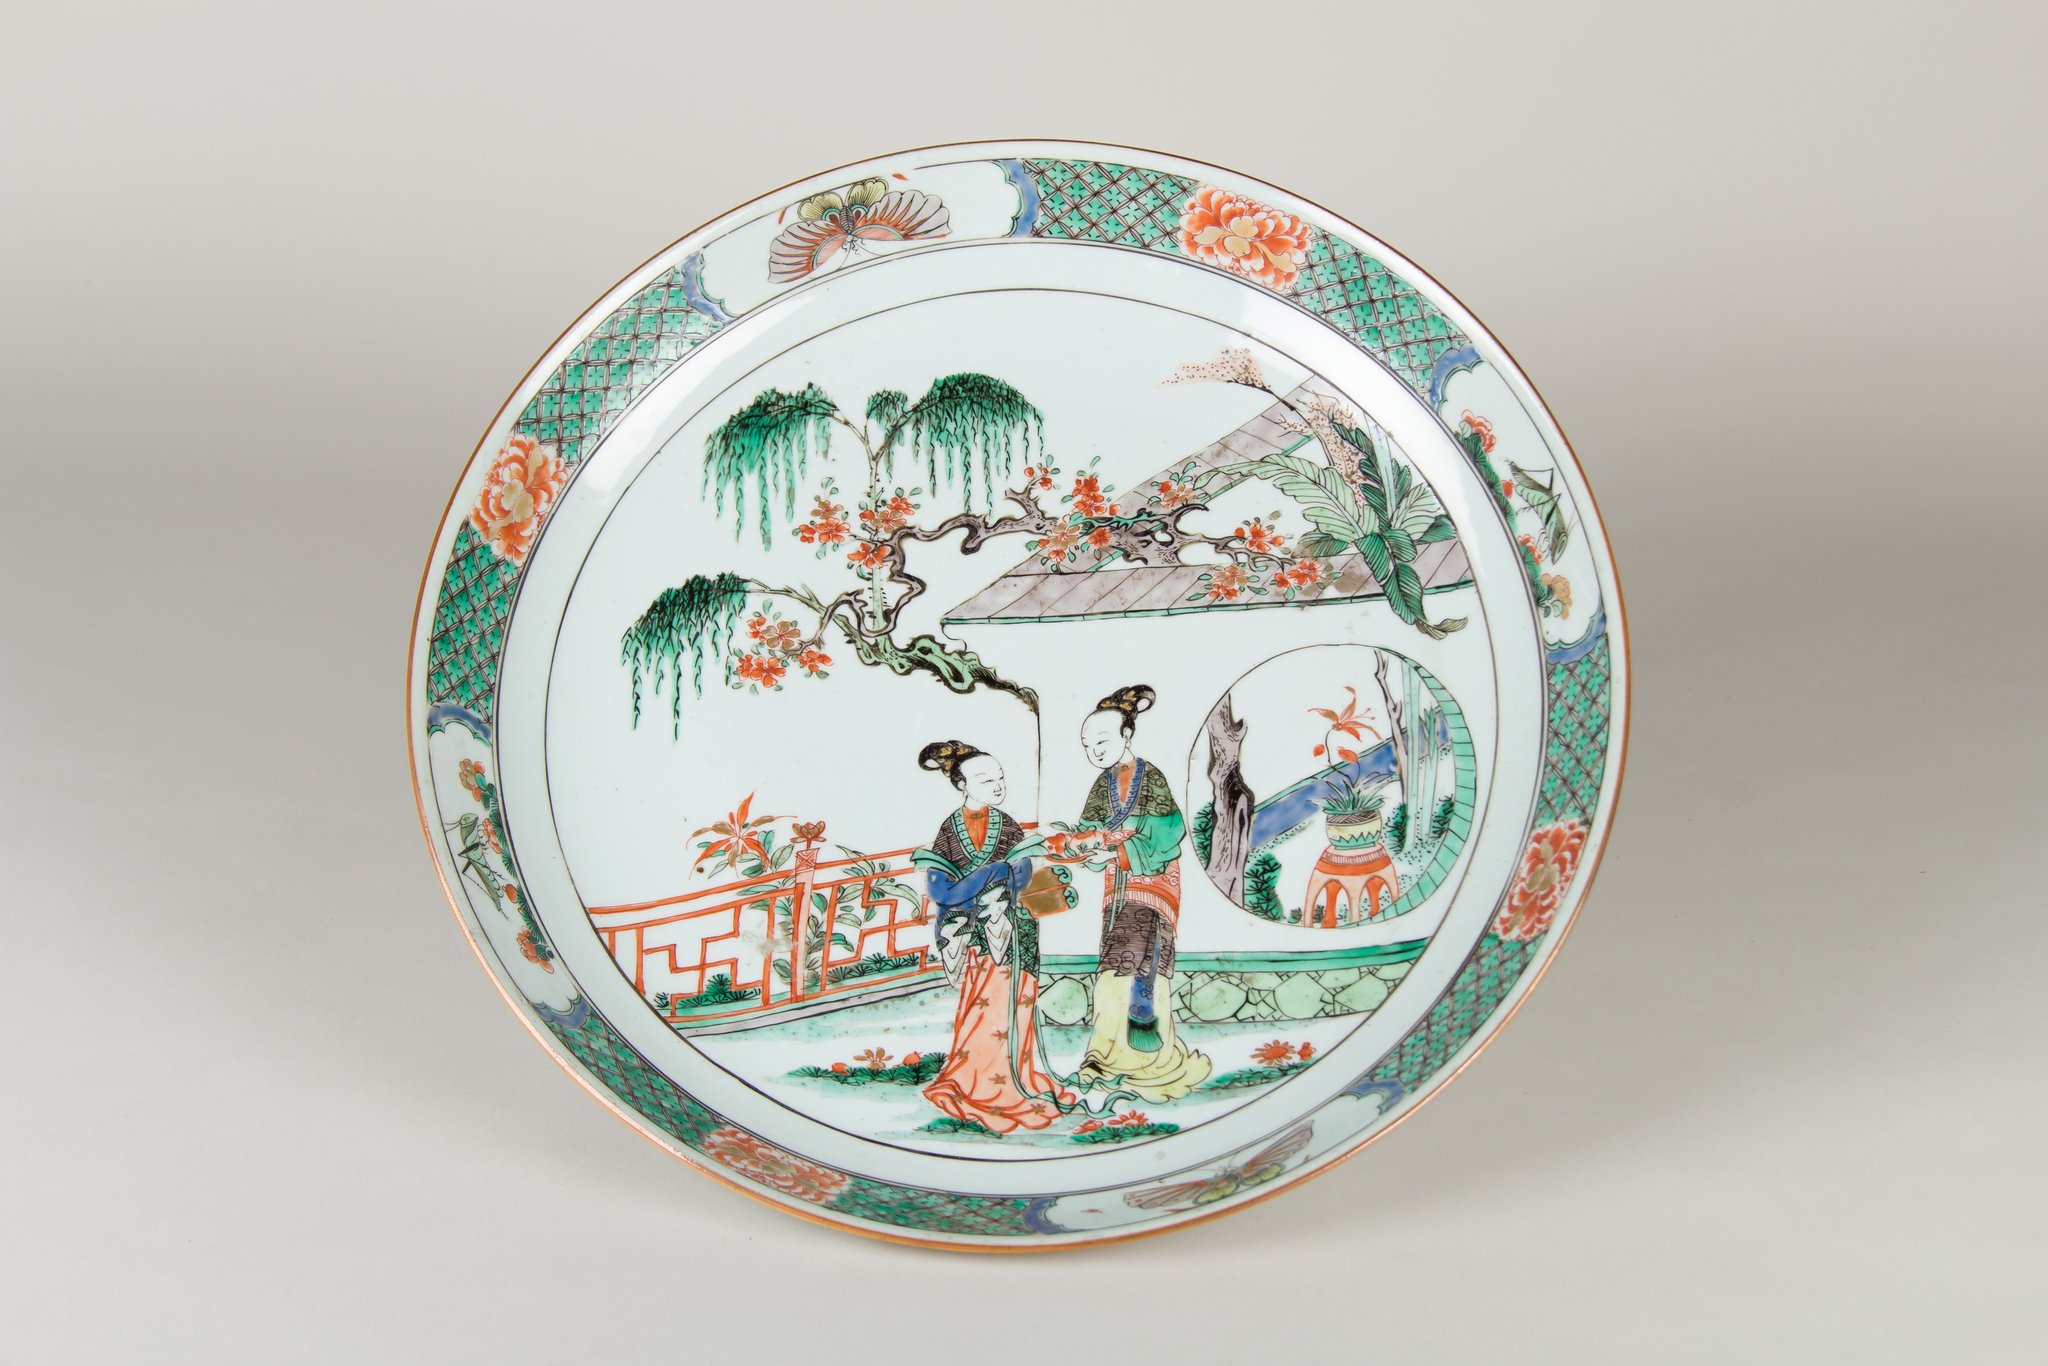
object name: plate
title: Plate with ladies in a garden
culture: chinese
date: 1667-1733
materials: enamel, porcelain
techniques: overglaze, painting, polychrome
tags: women